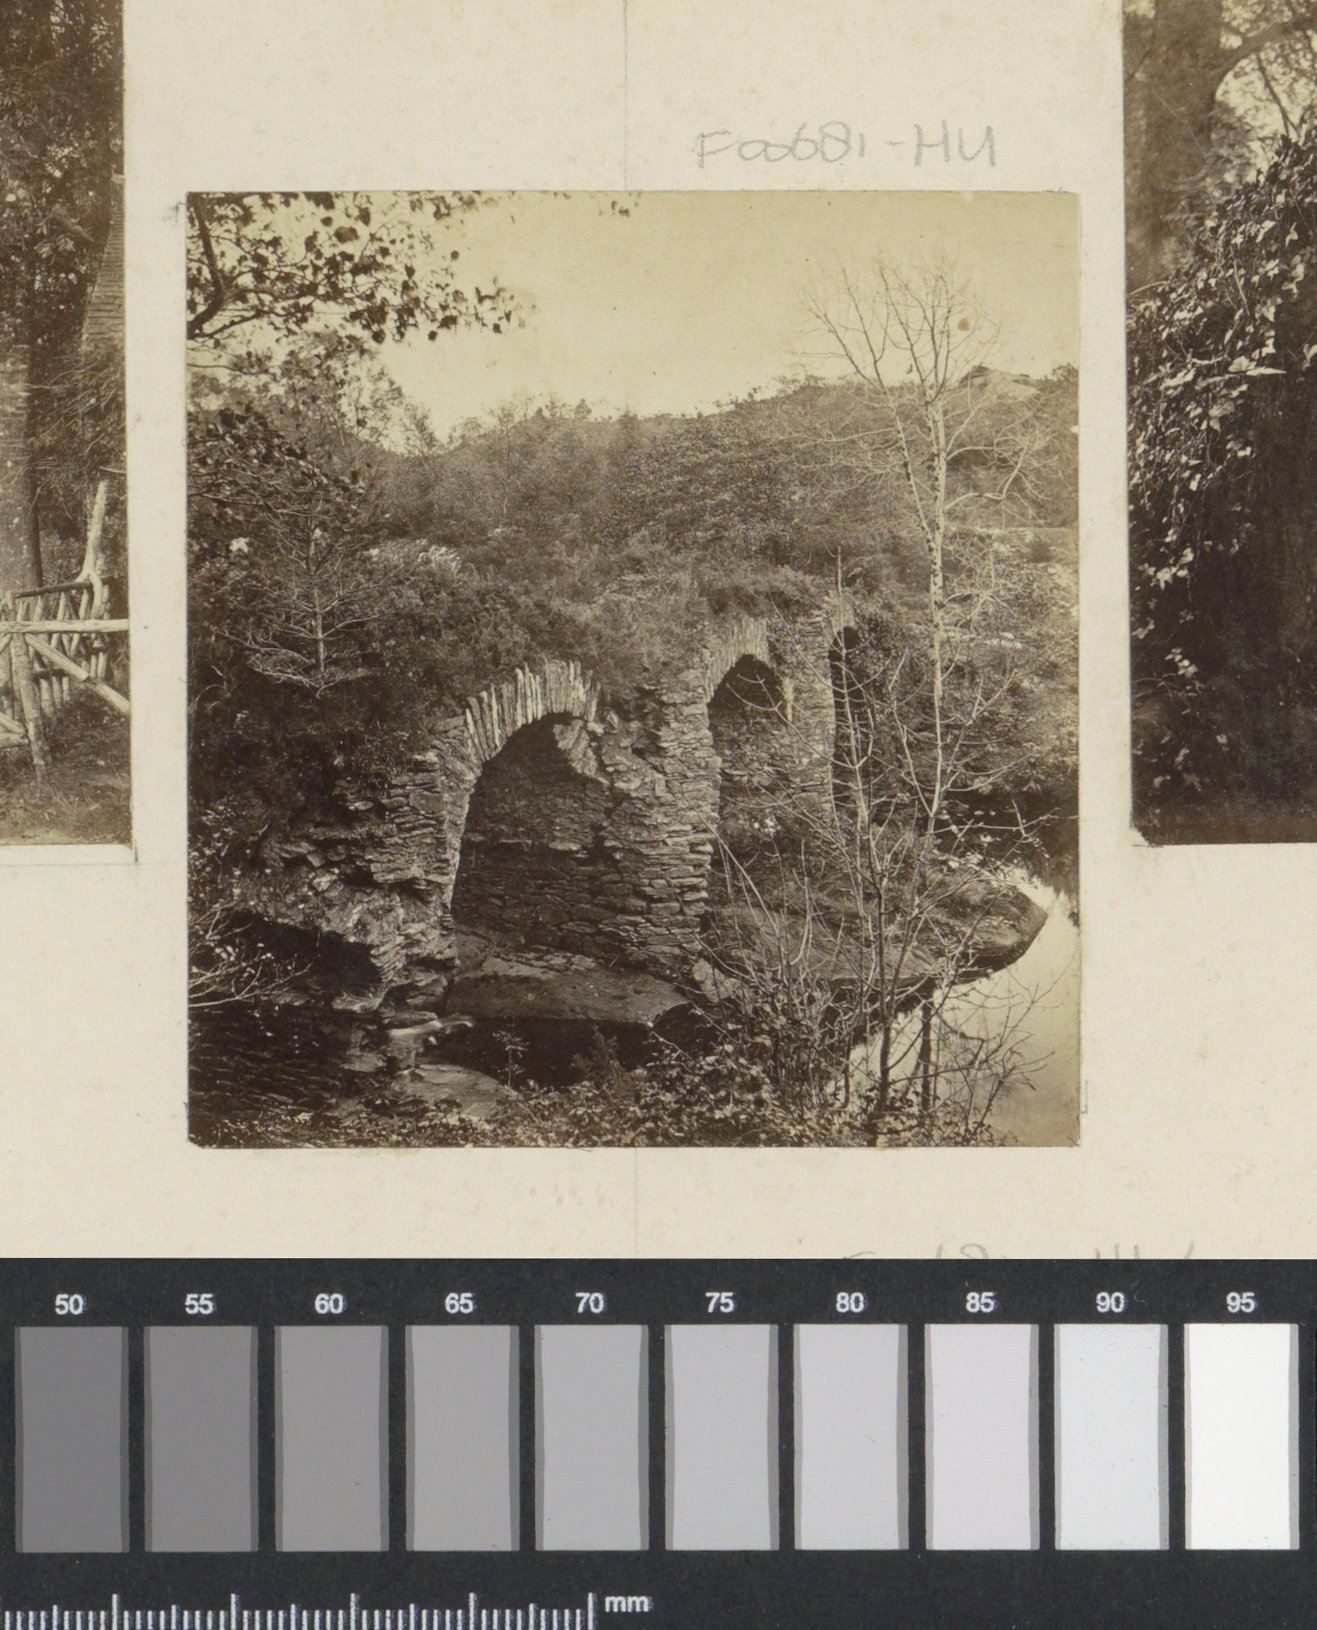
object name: photograph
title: Landschap met een overwoekerde brug in Engeland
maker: Anonymous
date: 1850-1870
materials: paper, photographic support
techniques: albumen print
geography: england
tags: ruin of a dwelling, house, castle, etc., england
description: Onderdeel van Album met foto's van bezienswaardigheden en landschappen in Engeland en van kunst.